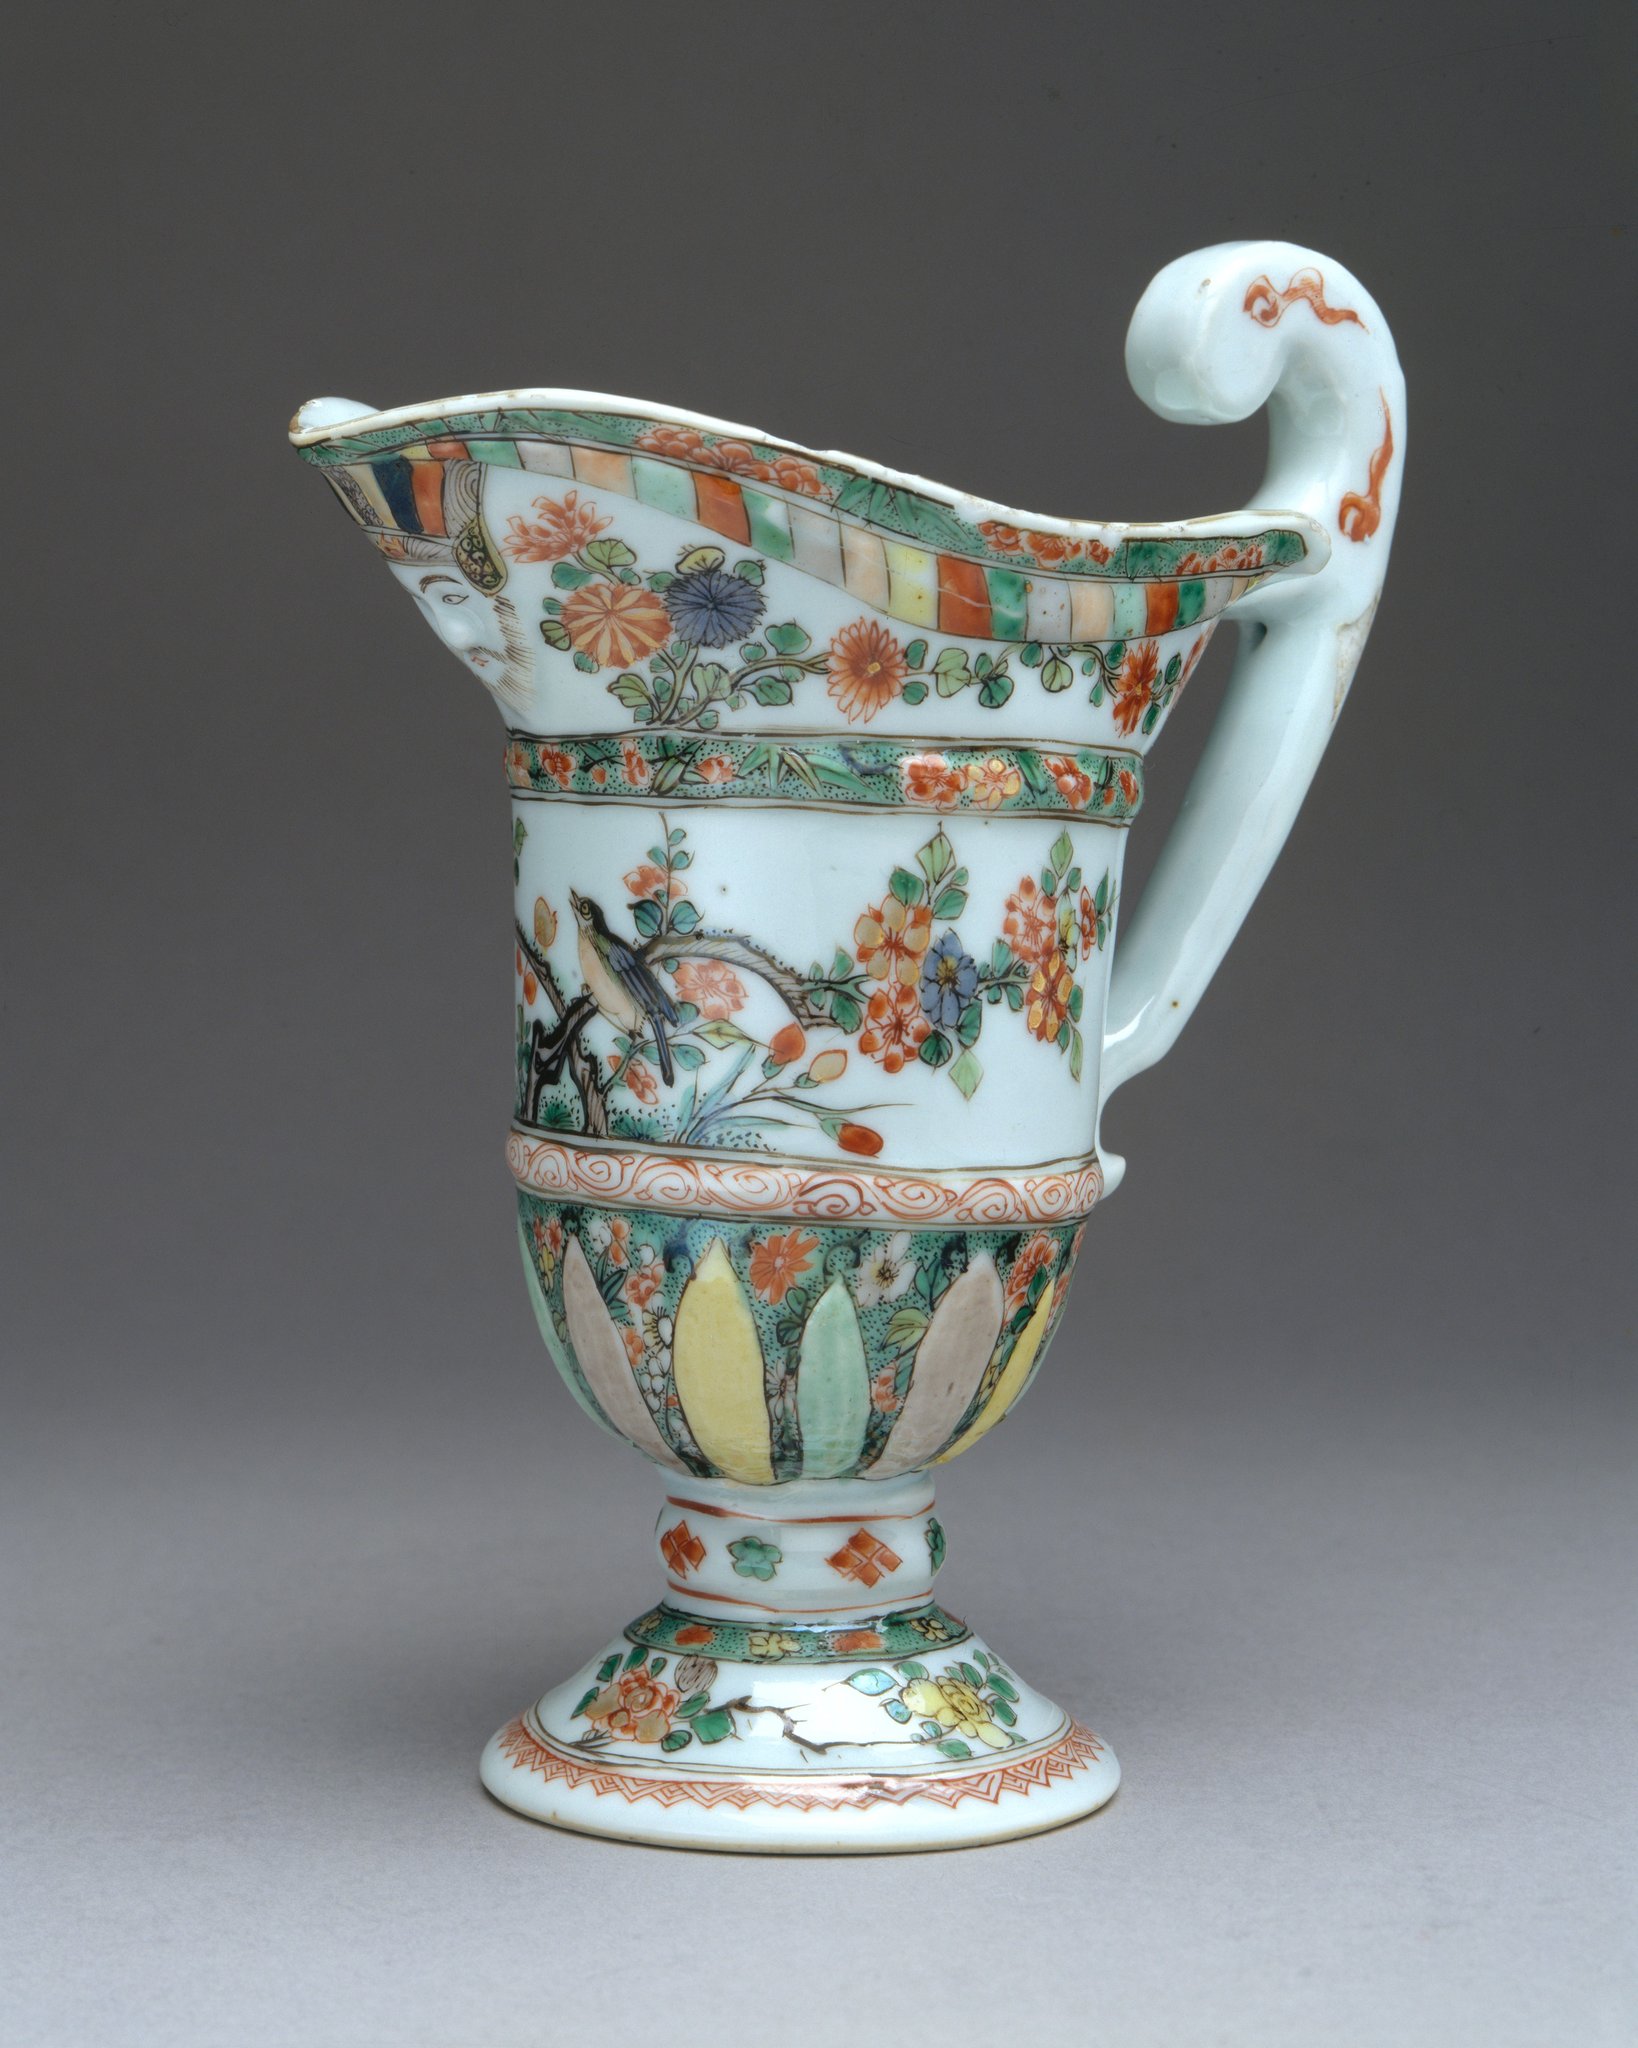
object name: ewer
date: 1715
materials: hard paste porcelain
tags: birds,faces,flowers